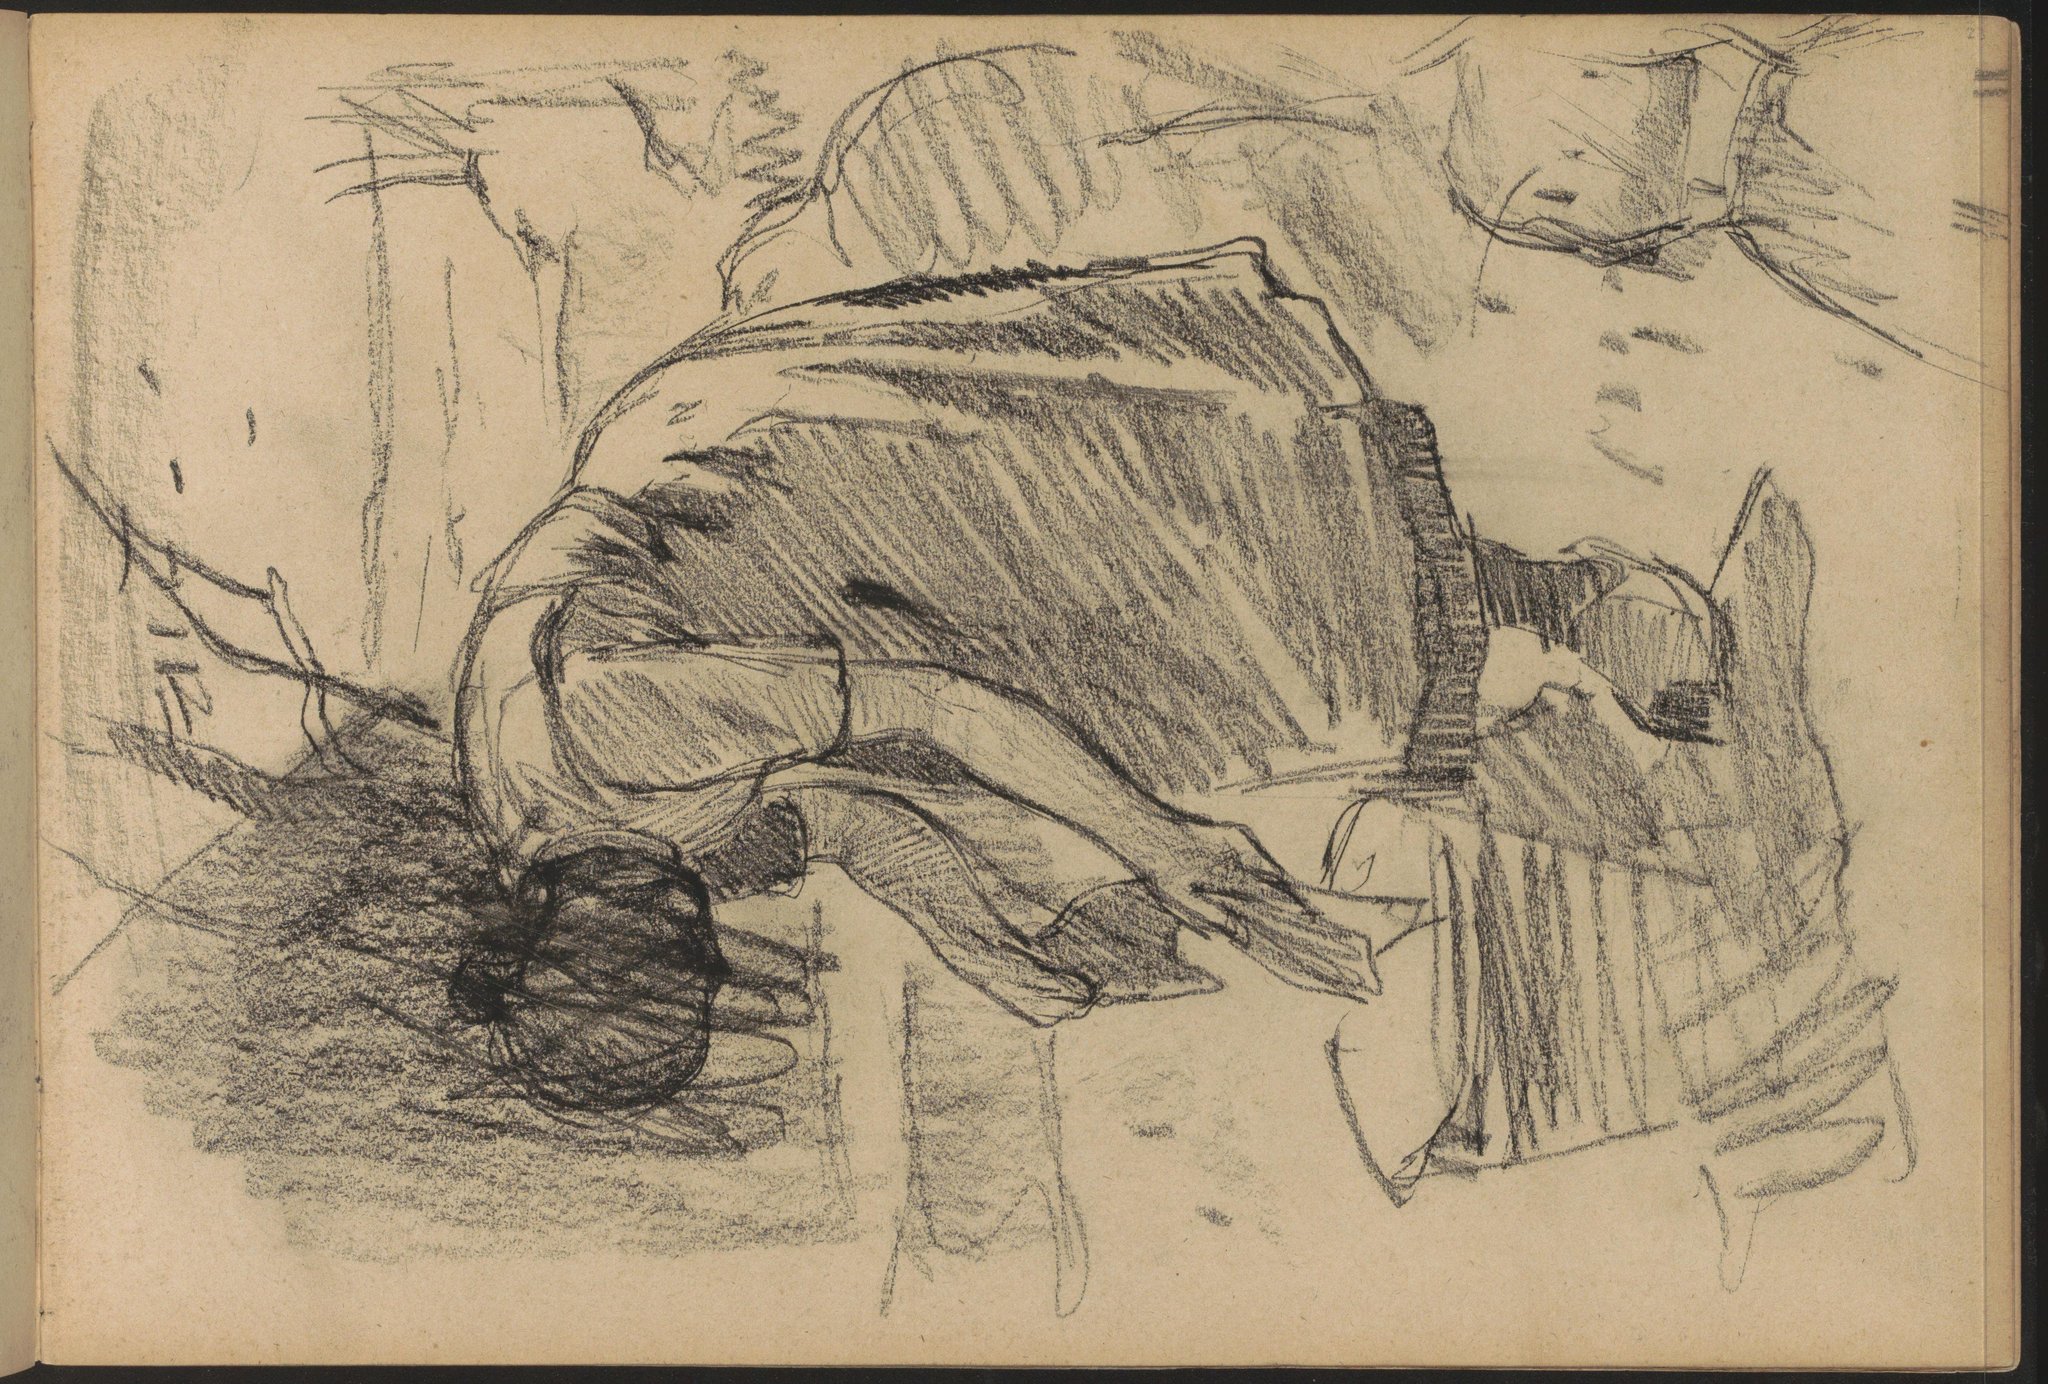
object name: sketchbook leaf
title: Boerin wassend in een emmer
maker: willem witsen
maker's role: draughtsman, painter, print maker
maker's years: 1860-1923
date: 1882-1886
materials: chalk, paper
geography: ewijkshoeve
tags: bending figure - aa - female human figure, adult woman (+ back view), container made of plant material other than wood: basket, container of metal: bucket, can, canister, drum, tin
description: Achter haar een boerderij. Onder een studie van een vrouw, op de rug gezien. Pagina 23 uit een schetsboek met 19 bladen.